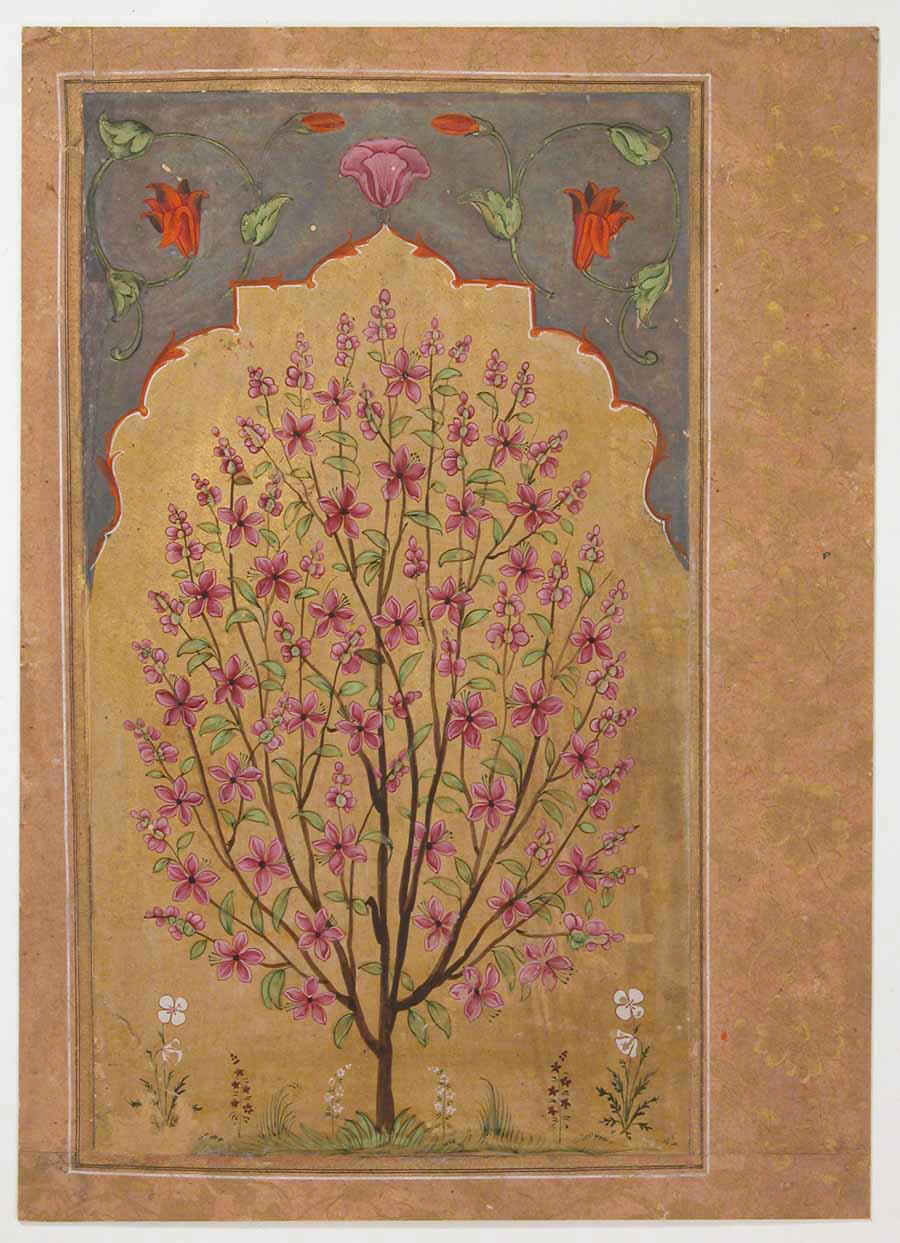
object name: illustrated album leaf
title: Flowering Tree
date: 1700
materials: gold, paper, watercolor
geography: india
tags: flowers,trees